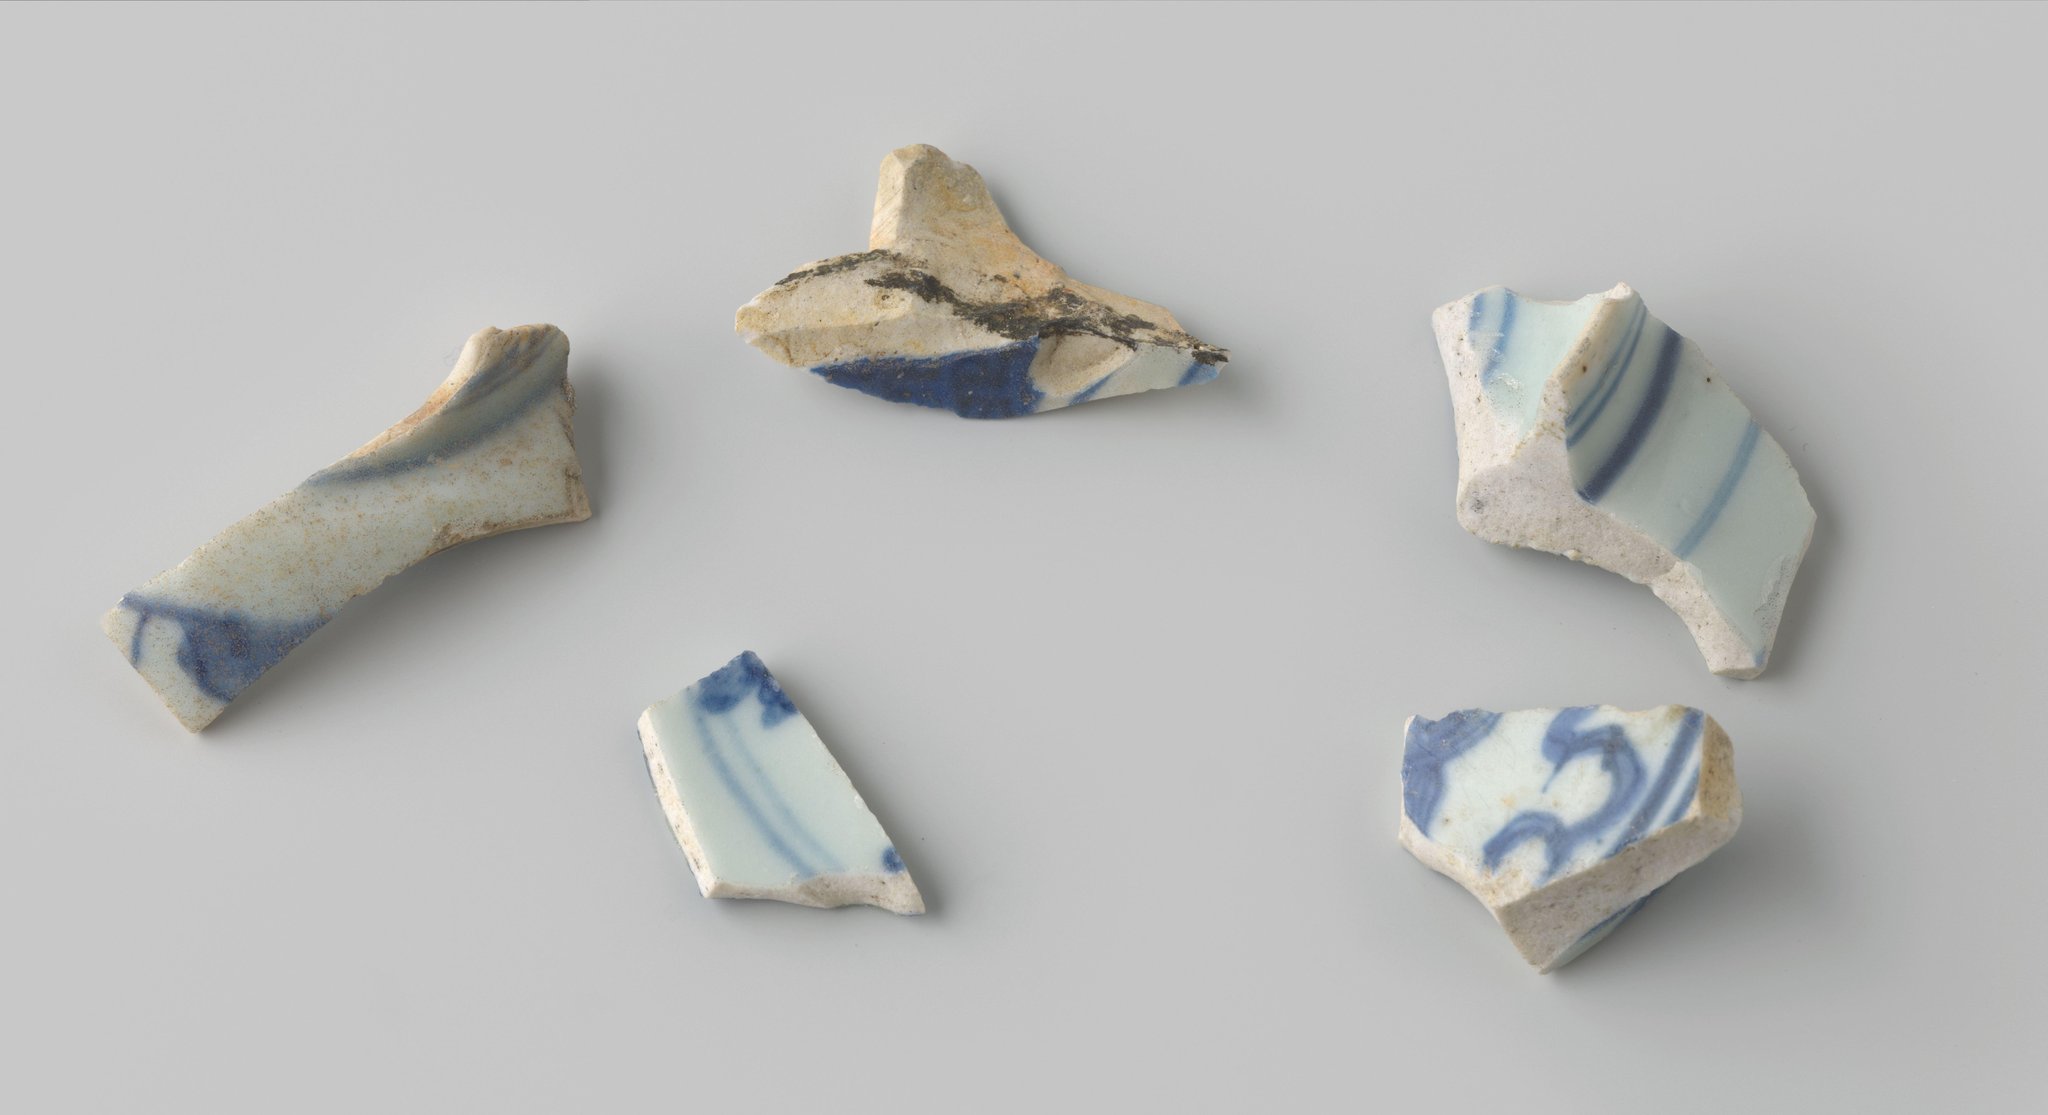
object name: bowl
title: Scherven van kommen uit V.O.C.-schip de 'Witte Leeuw'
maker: Anonymous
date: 1613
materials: porcelain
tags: verenigde oostindische compagnie, sint-helena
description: Scherven van kommen uit V.O.C.-schip de 'Witte Leeuw'.